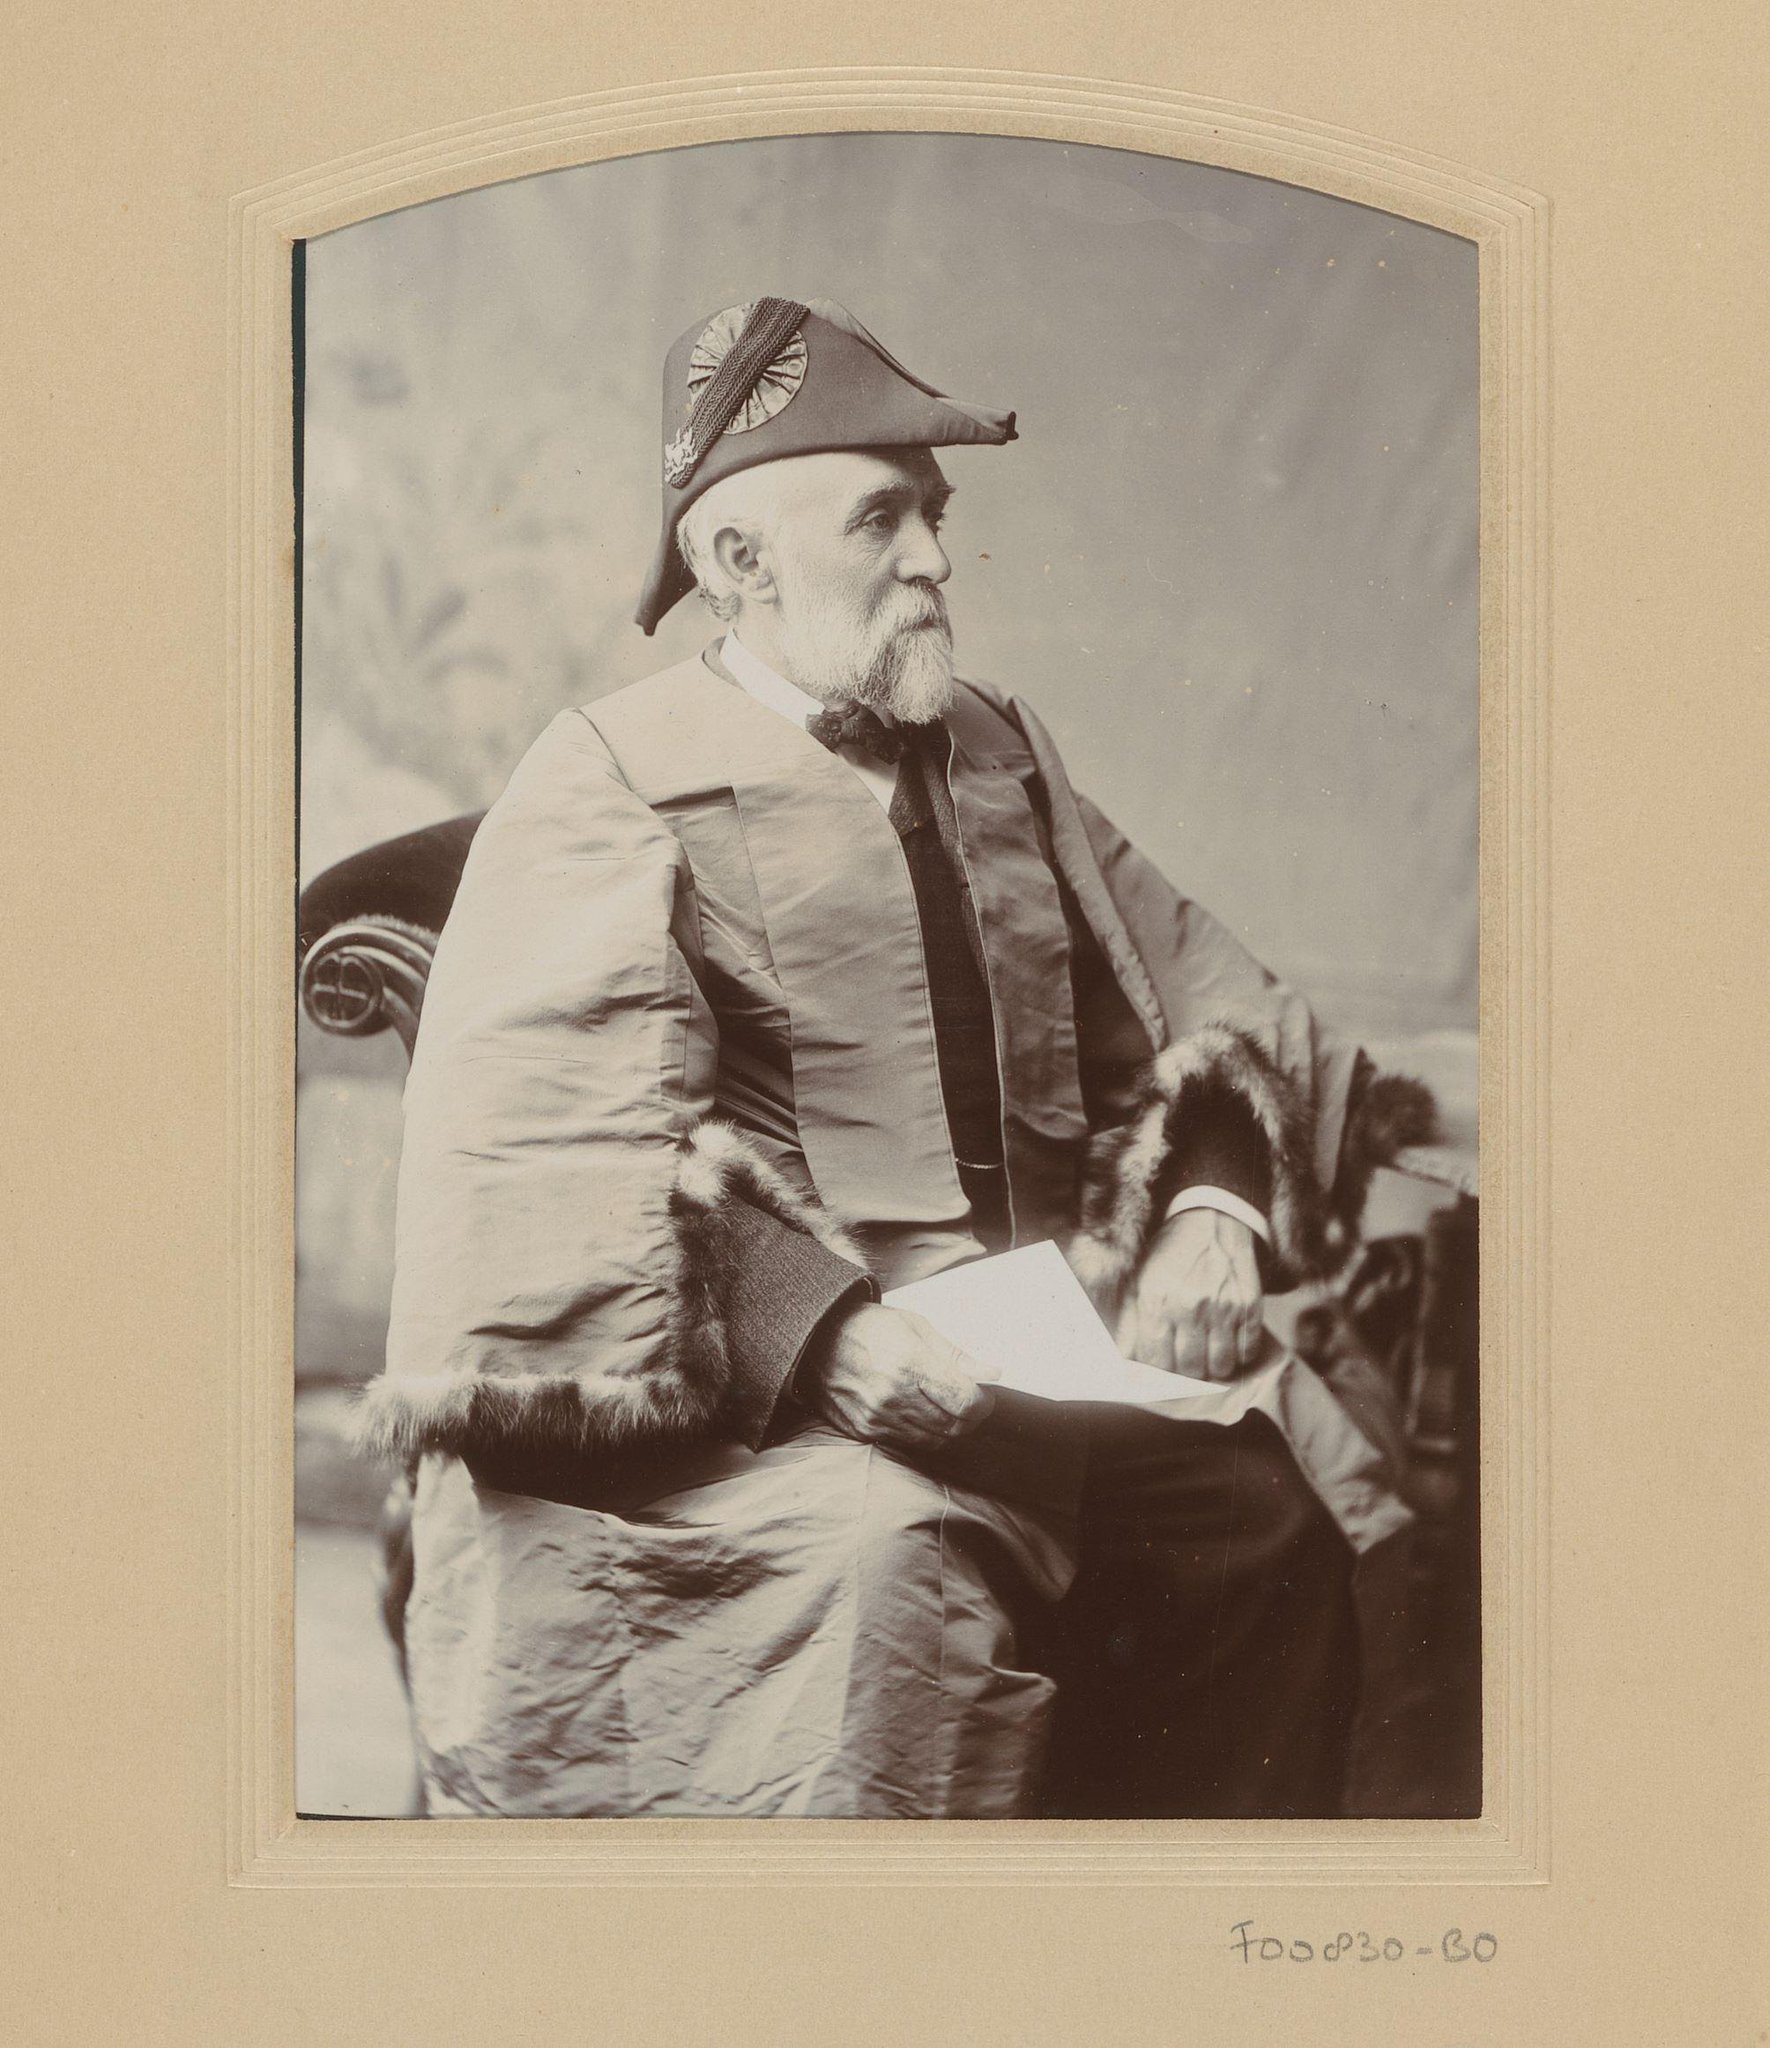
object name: photograph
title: Portret van een zittende man in toga met steek op en brief in de hand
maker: william george henry wright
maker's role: fotograaf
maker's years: 1860-1915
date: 1880-1910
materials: cardboard, photographic support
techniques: collodion silver print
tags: head-gear, adult man, historical persons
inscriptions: inscription: ‘W. Wright/ 83. Bishopsgate/ City’